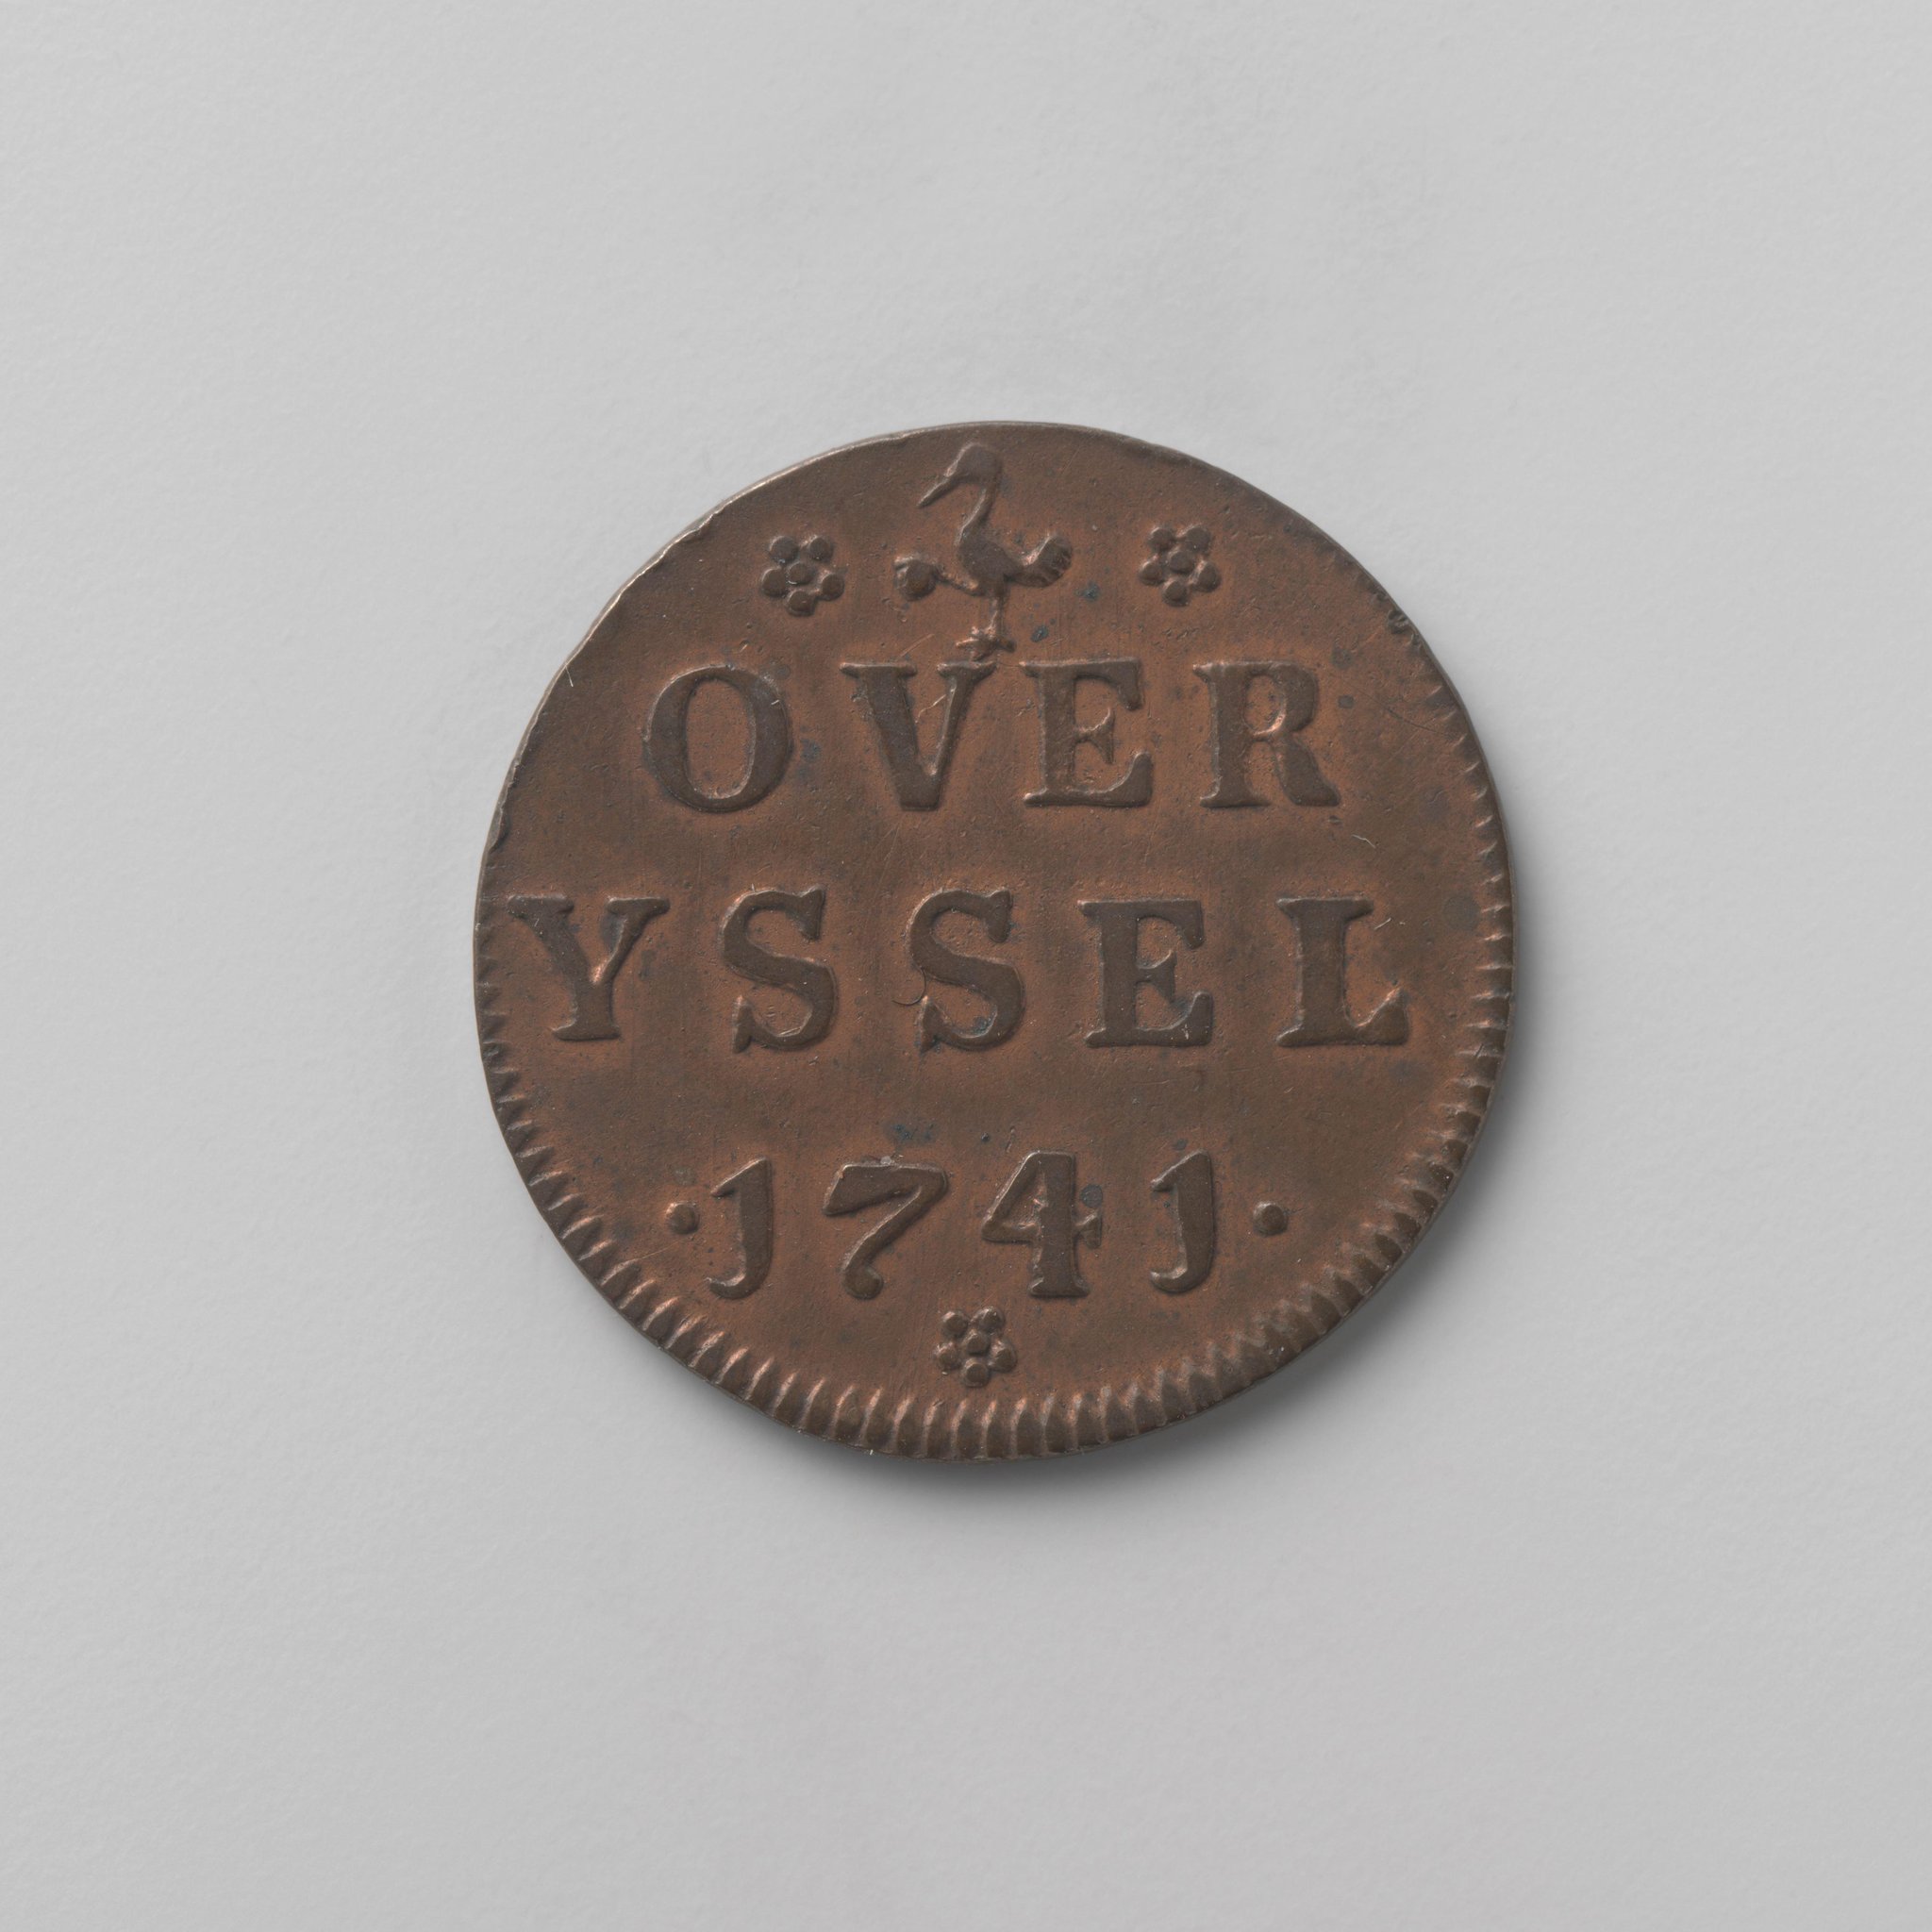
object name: coin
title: Overijssel, duit, 1741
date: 1741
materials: copper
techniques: striking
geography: kampen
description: Koperen munt. Voorzijde: tussen wapenspreuk gekroond provinciaal wapenschild. Keerzijde: tweeregelig opschrift, waarboven muntmeesterteken en waaronder jaartal.